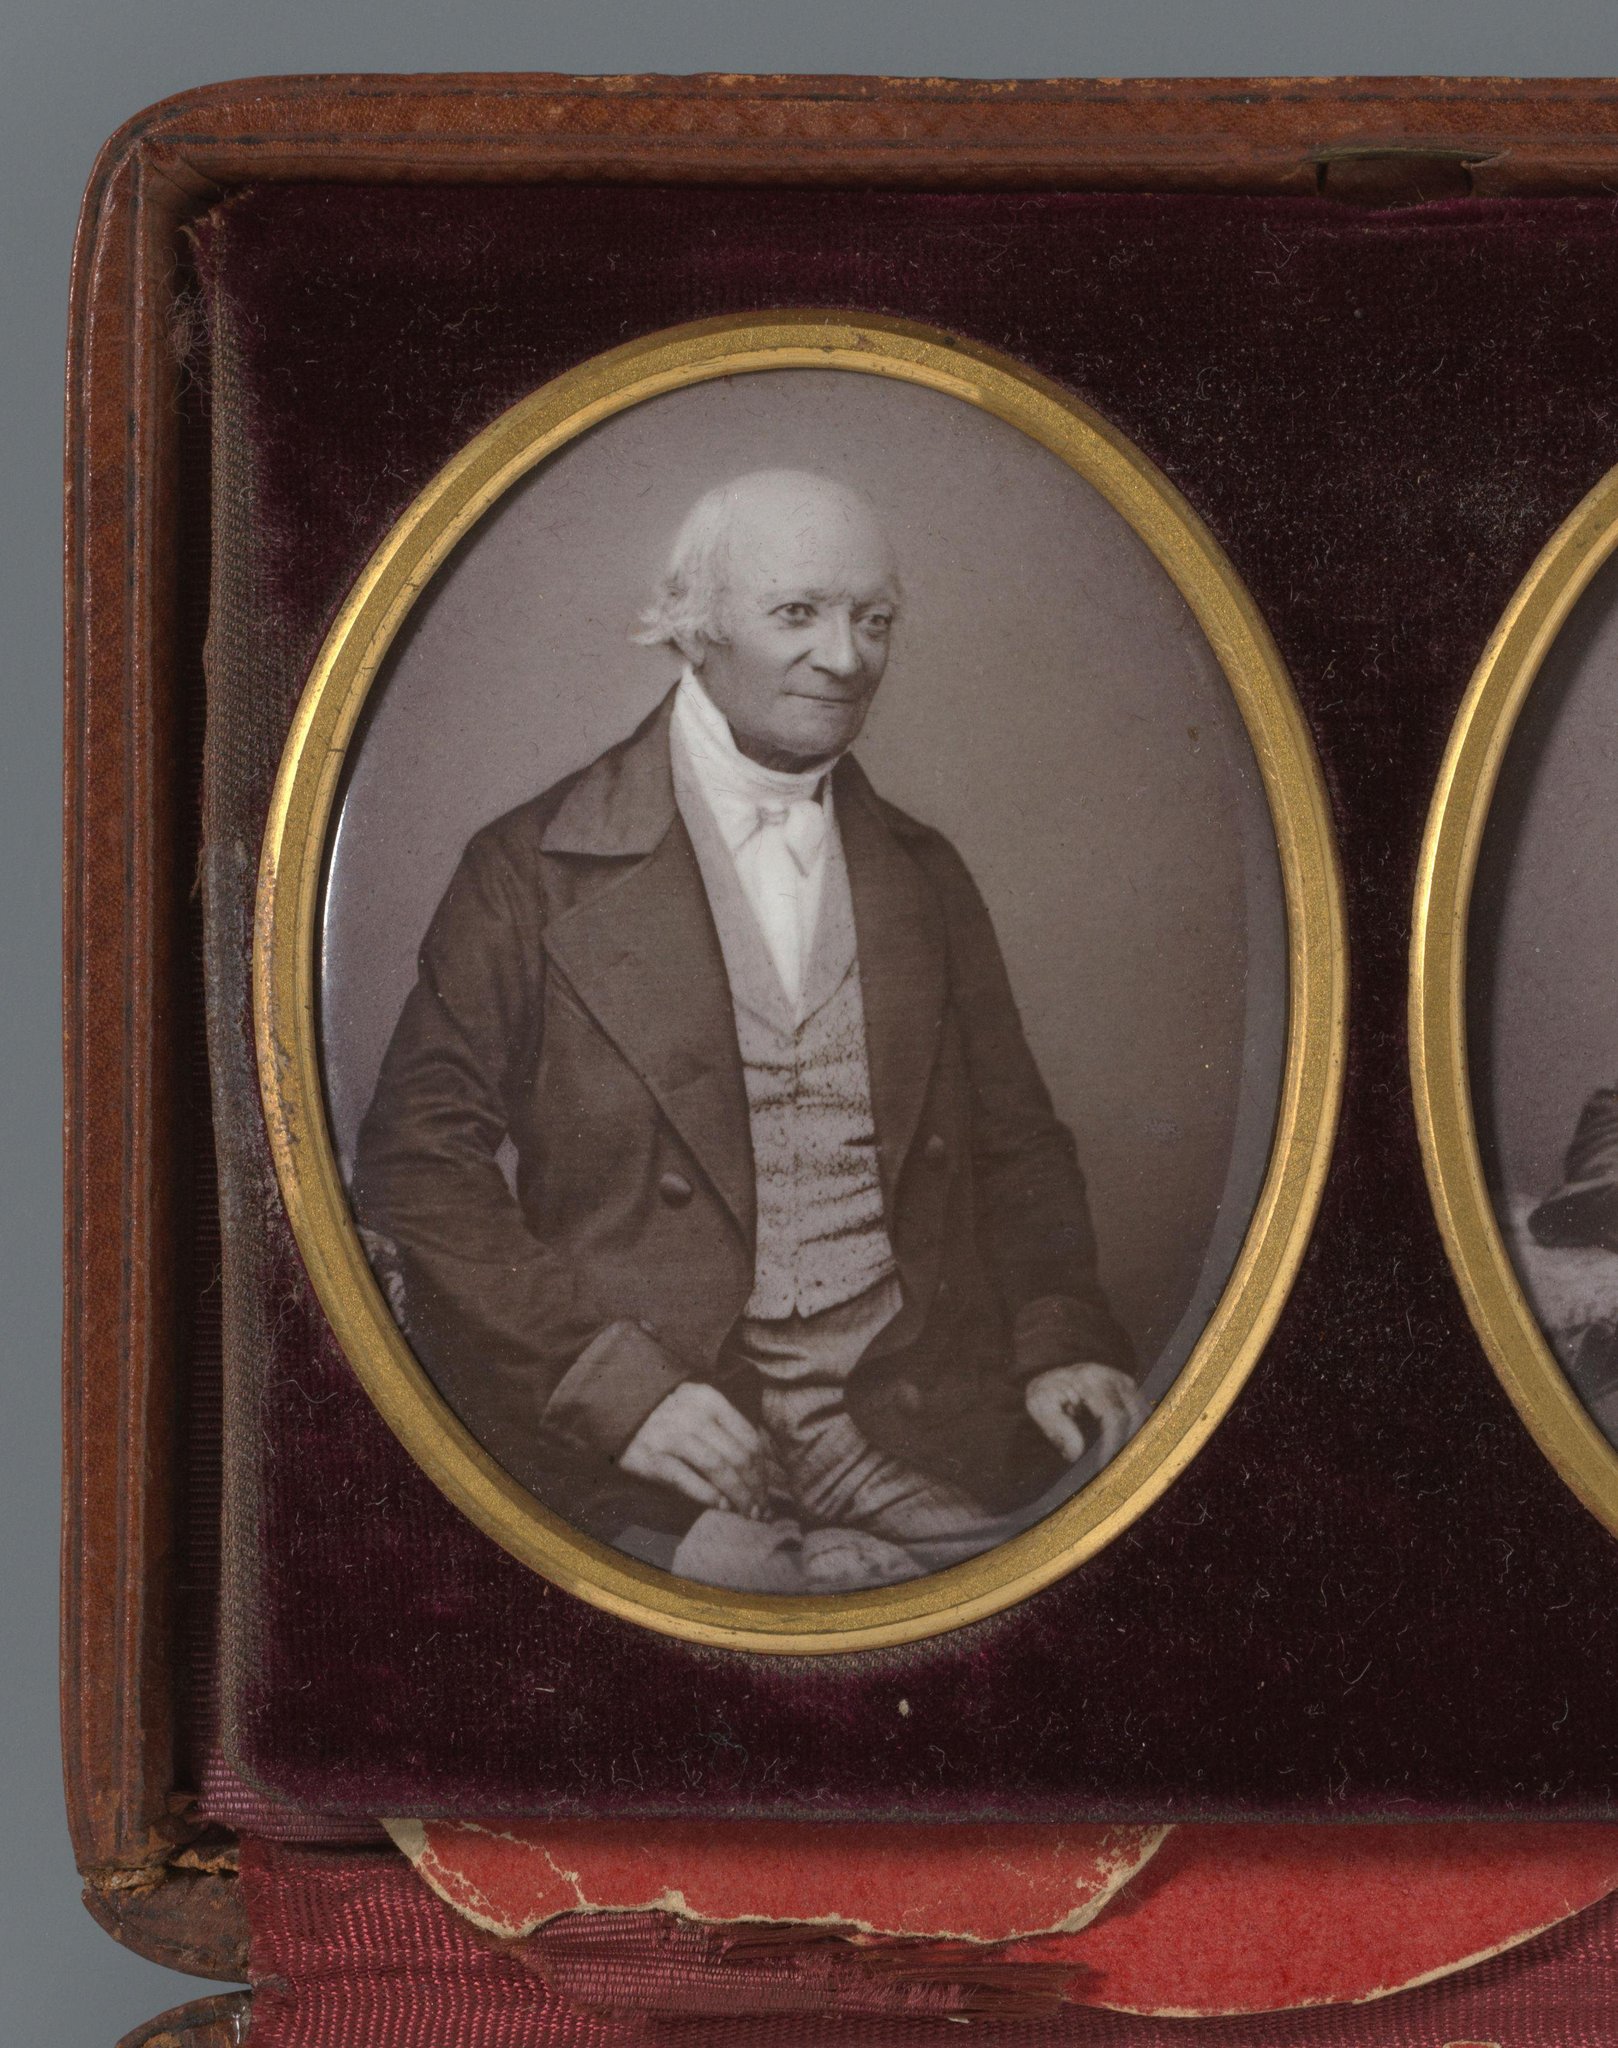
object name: étui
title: Portret van een onbekende oude vrouw in etui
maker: mathieu deroche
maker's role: fotograaf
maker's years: 1837-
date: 1875-1890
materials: leather, metal, silk, velvet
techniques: enamel photograph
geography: paris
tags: old woman, anonymous historical person portrayed, paris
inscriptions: inscription: ‘M.M.’, inscription: ‘Medaille D'argent/ 1867/ Procédé Mathieu Deroche/ Vienne - 1873/ Berthier/ Paris/ 1875/ Reproduction/ MD’